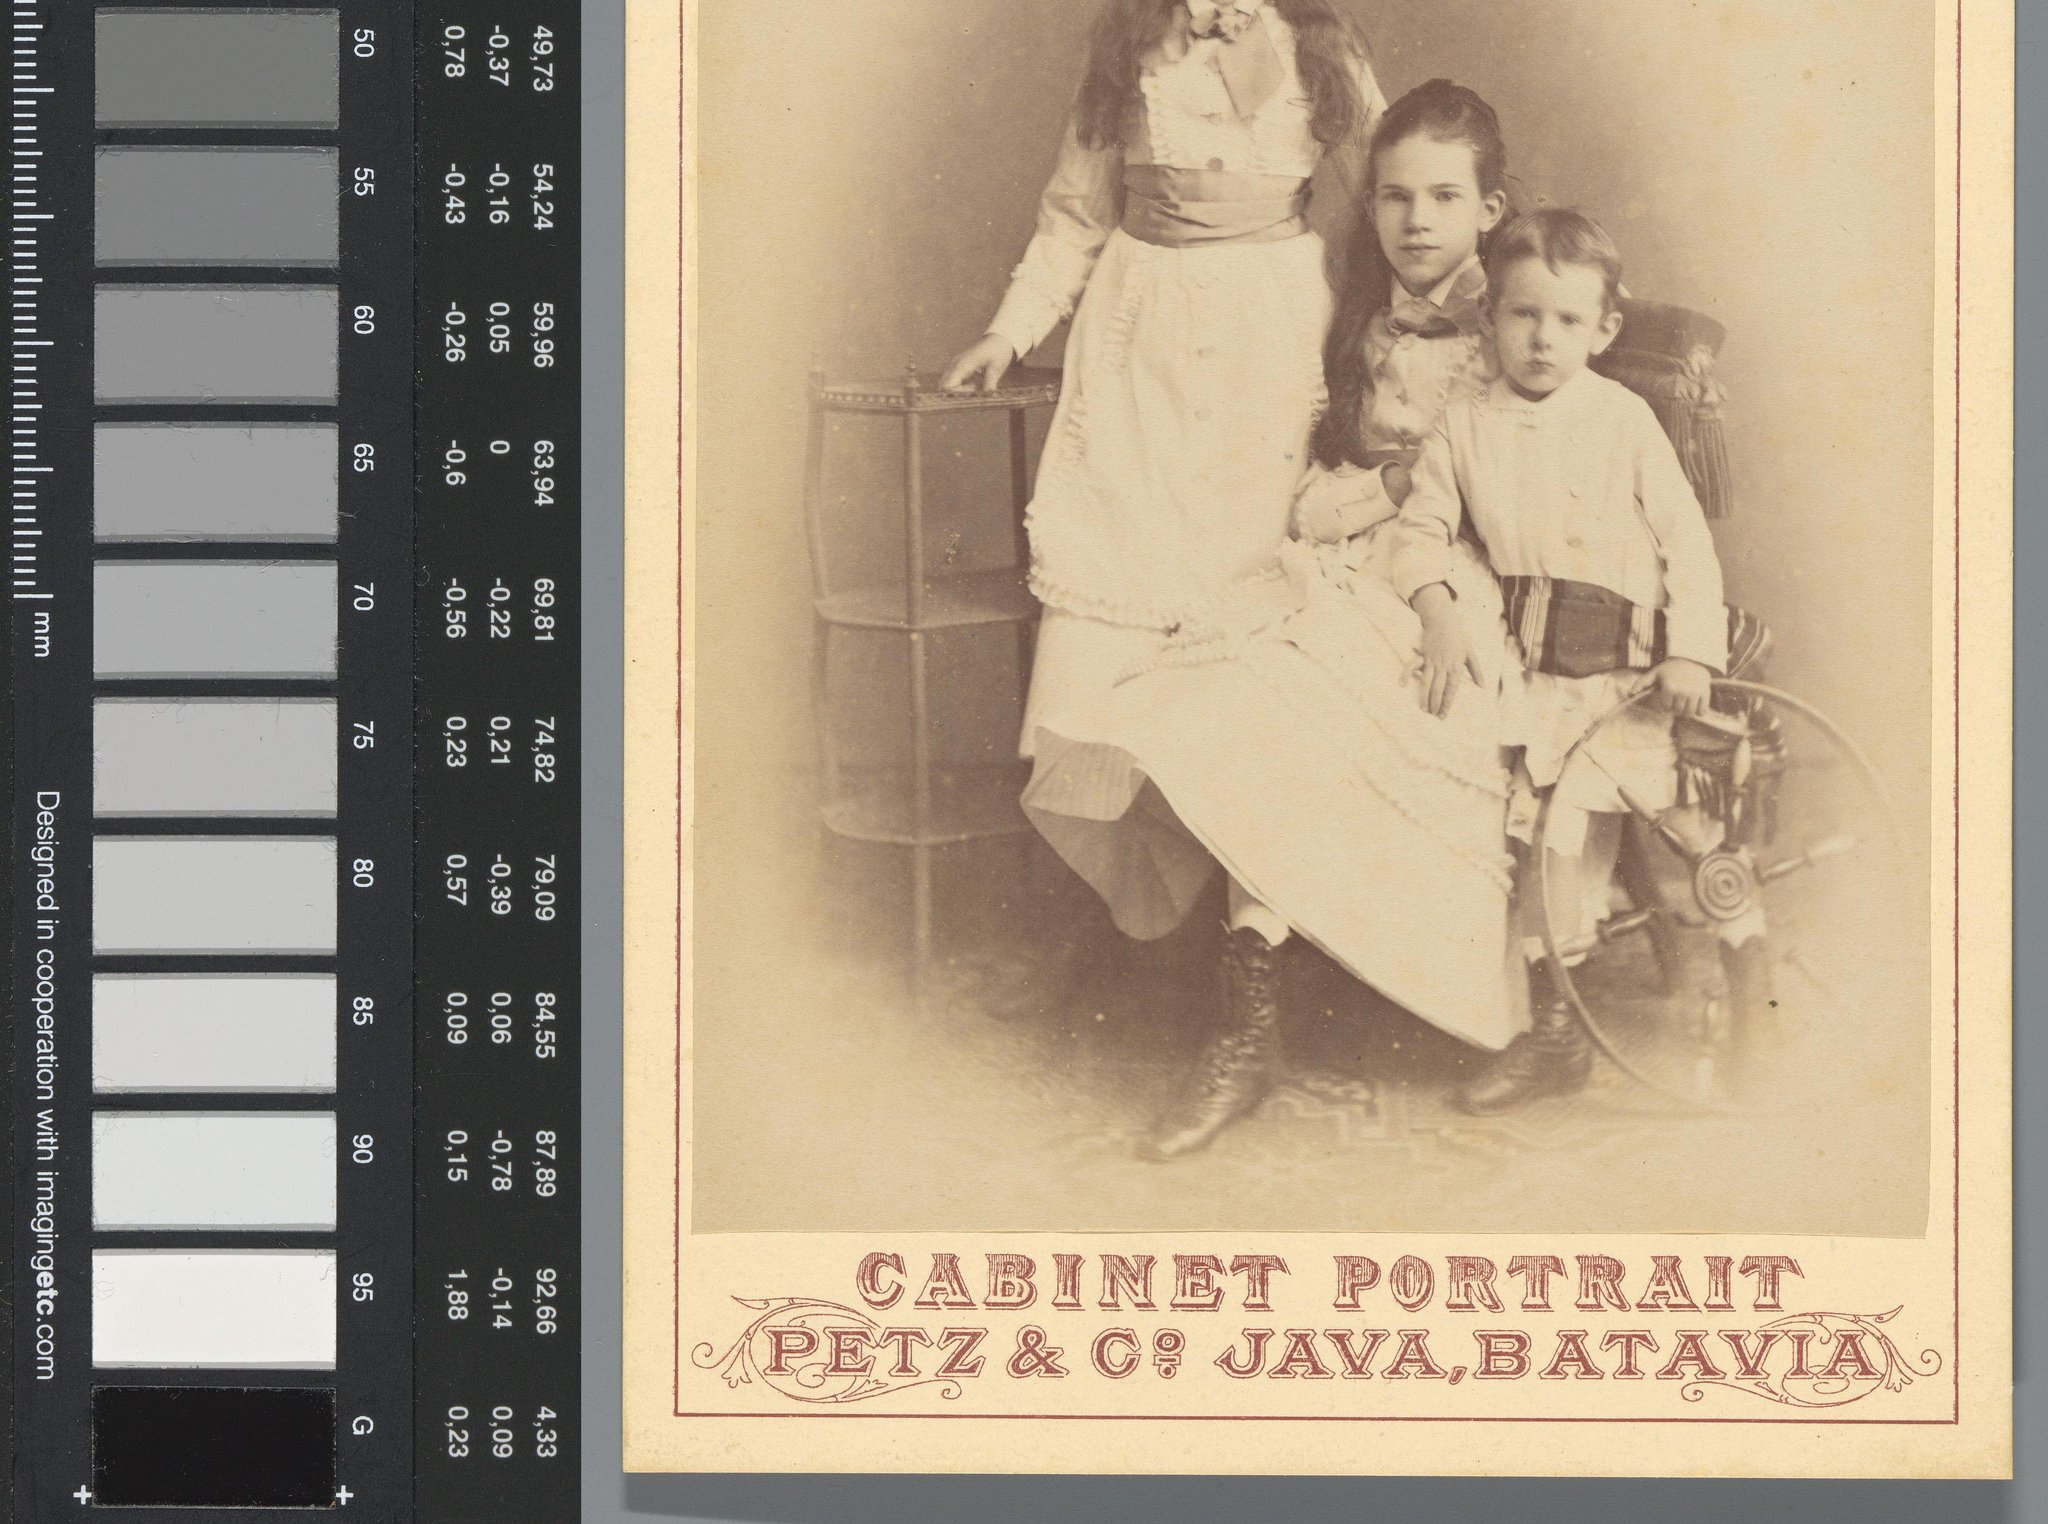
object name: cabinet photograph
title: Portret van drie kinderen van Van den Berg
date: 1877-1880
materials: cardboard, photographic support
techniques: albumen print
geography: java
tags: batavia, emilie albertine onnen-van den berg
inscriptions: inscription: ‘CABINET PORTRAIT / PETZ & Co JAVA, BATAVIA’, name: ‘Pam / Emilie van den Berg / Karel’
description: Staand meisje (Pam) met links van haar een zittend meisje (Emilie) en een staand jongetje (Karel).